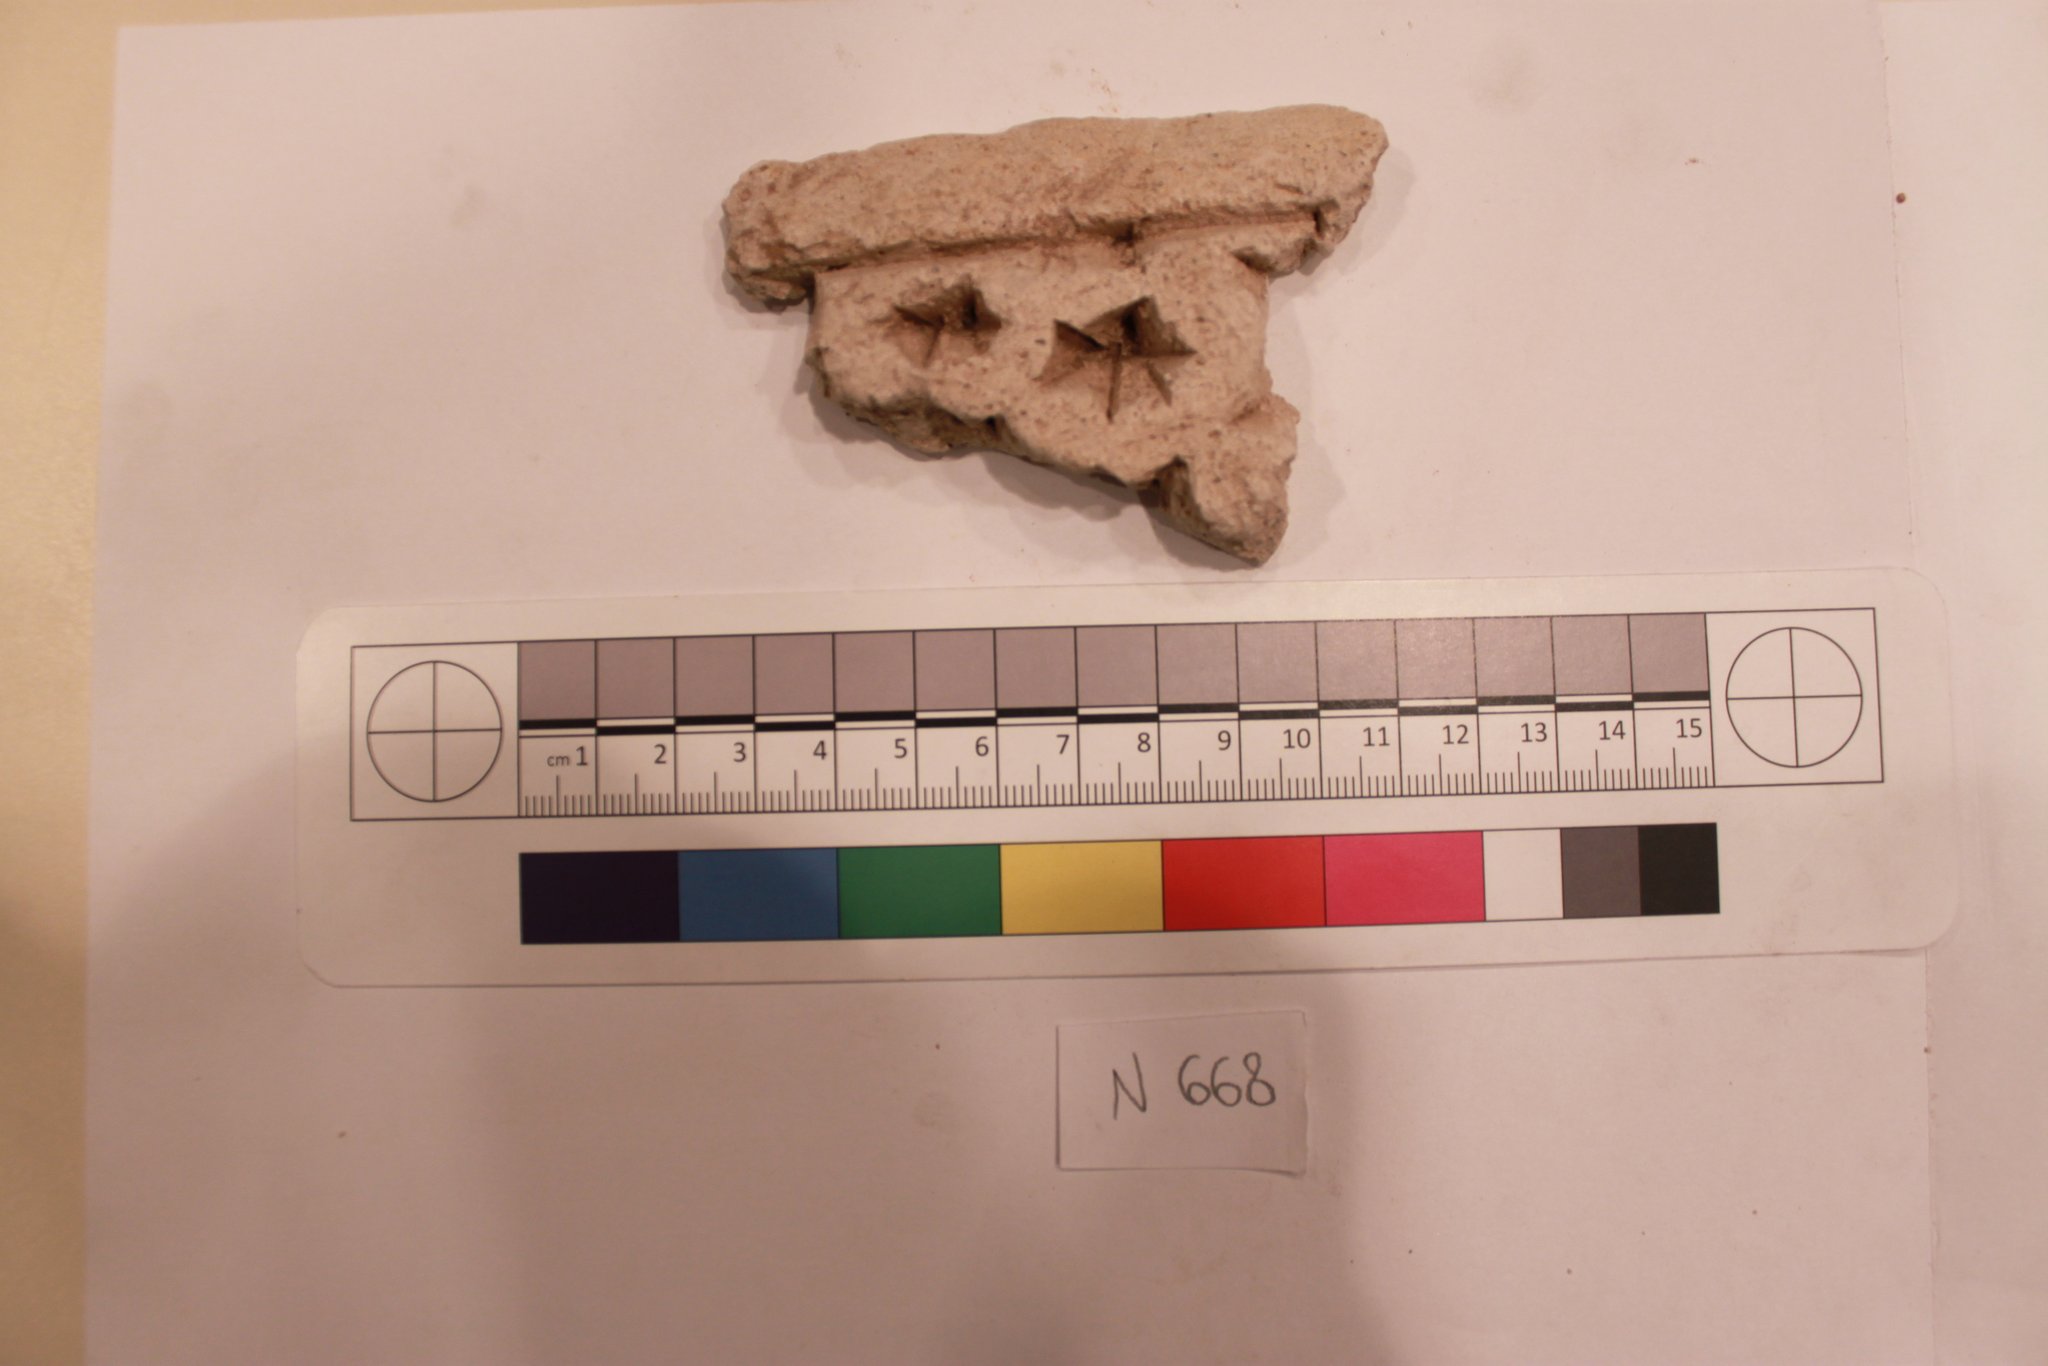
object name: fragment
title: Stucco Fragment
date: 701-1200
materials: plaster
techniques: carving, painting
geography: iran